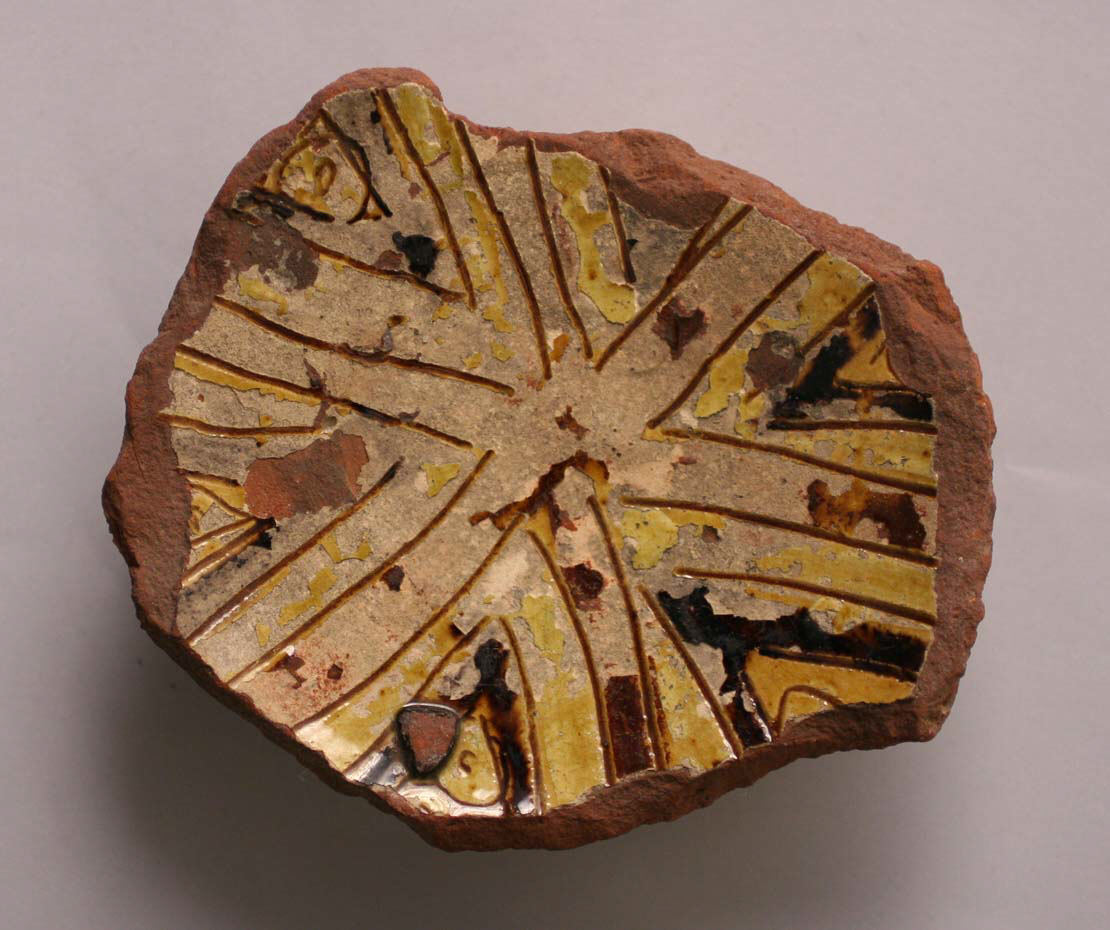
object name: ceramic fragment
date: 1301-1500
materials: earthenware, glaze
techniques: coloring, incising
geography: egypt